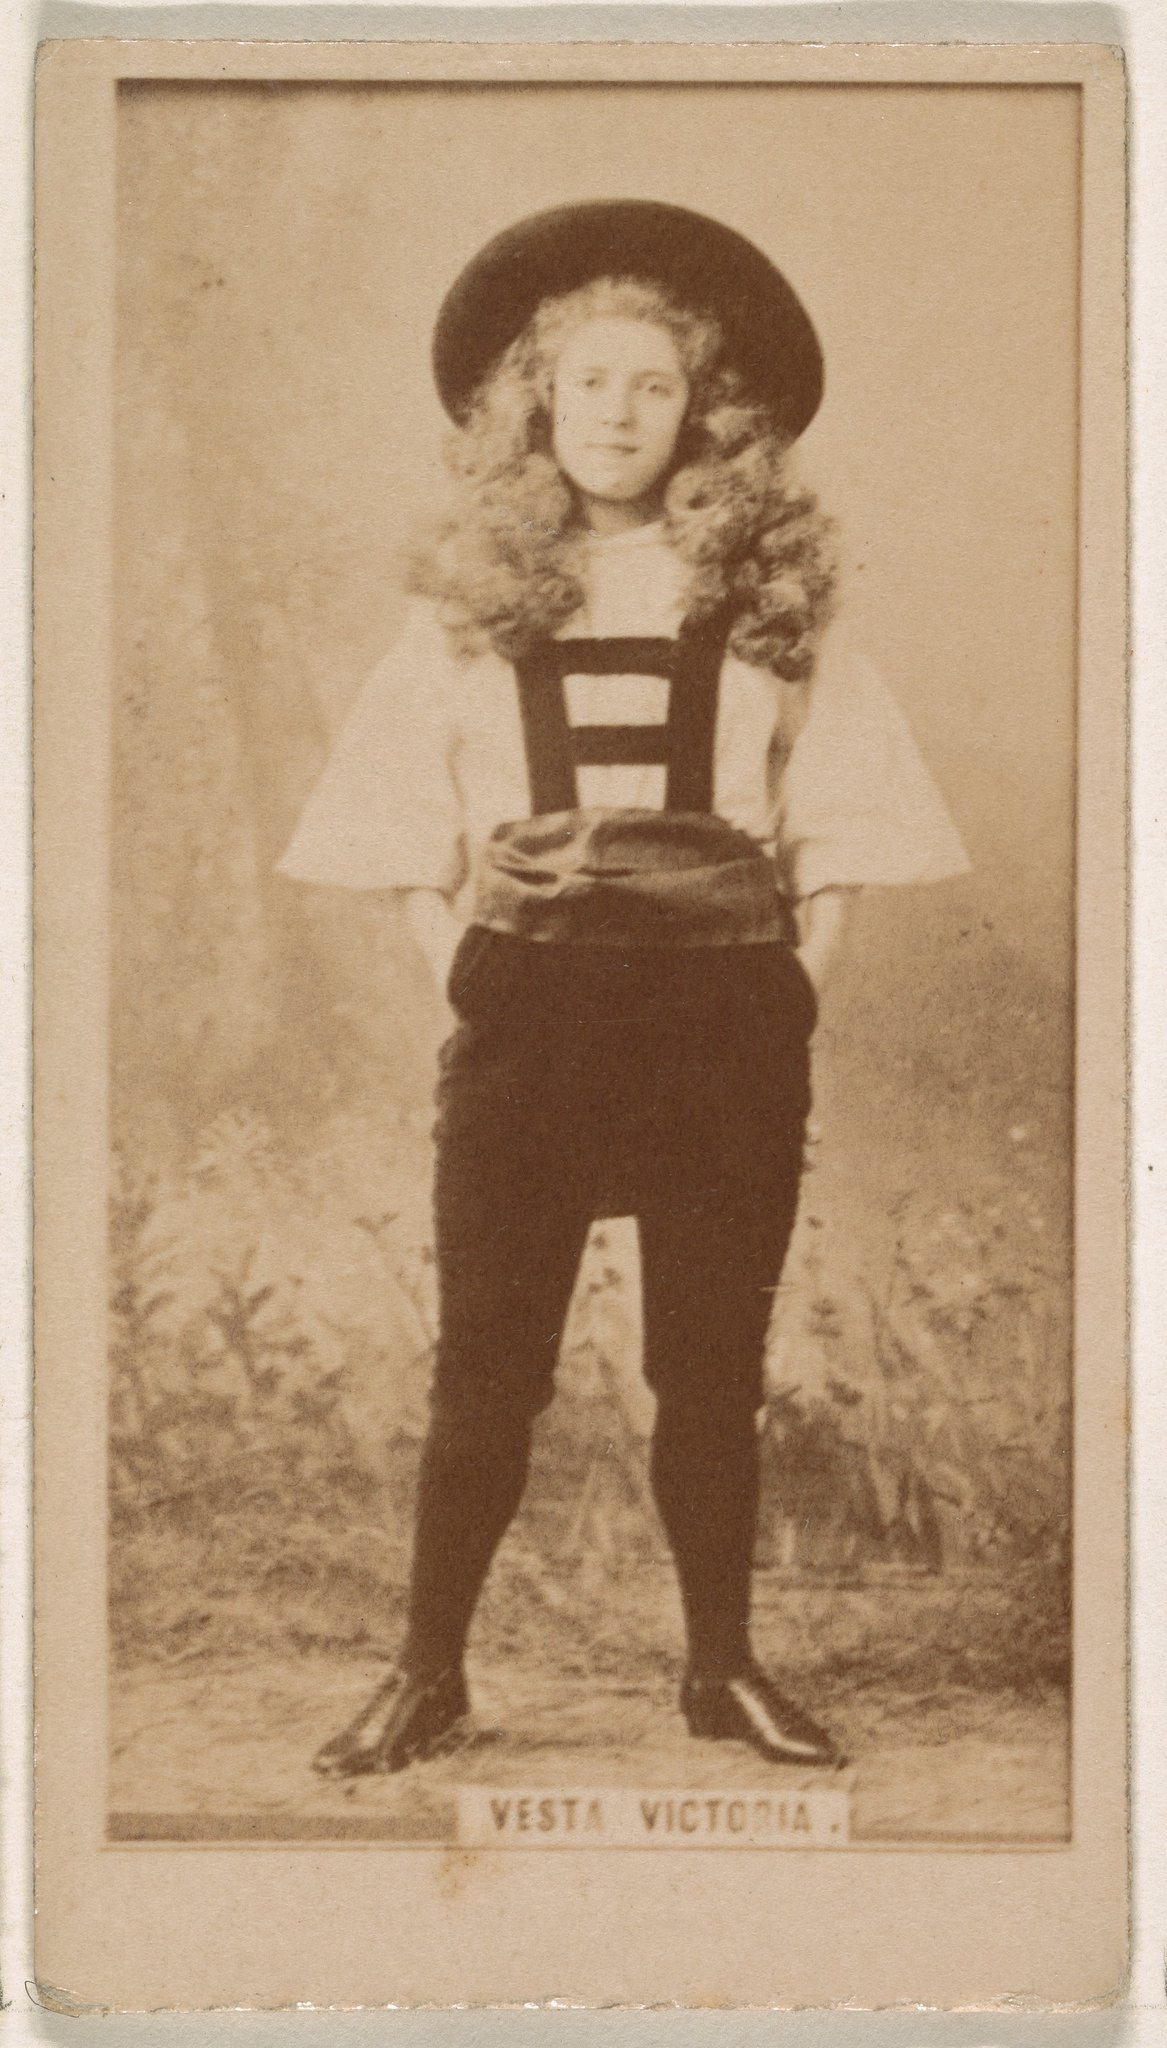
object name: photograph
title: Vesta Victoria, from the Actresses series (N245) issued by Kinney Brothers to promote Sweet Caporal Cigarettes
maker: kinney brothers tobacco company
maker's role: publisher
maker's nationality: american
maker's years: 1869-2011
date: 1890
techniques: albumen silver print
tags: portraits,women,actresses